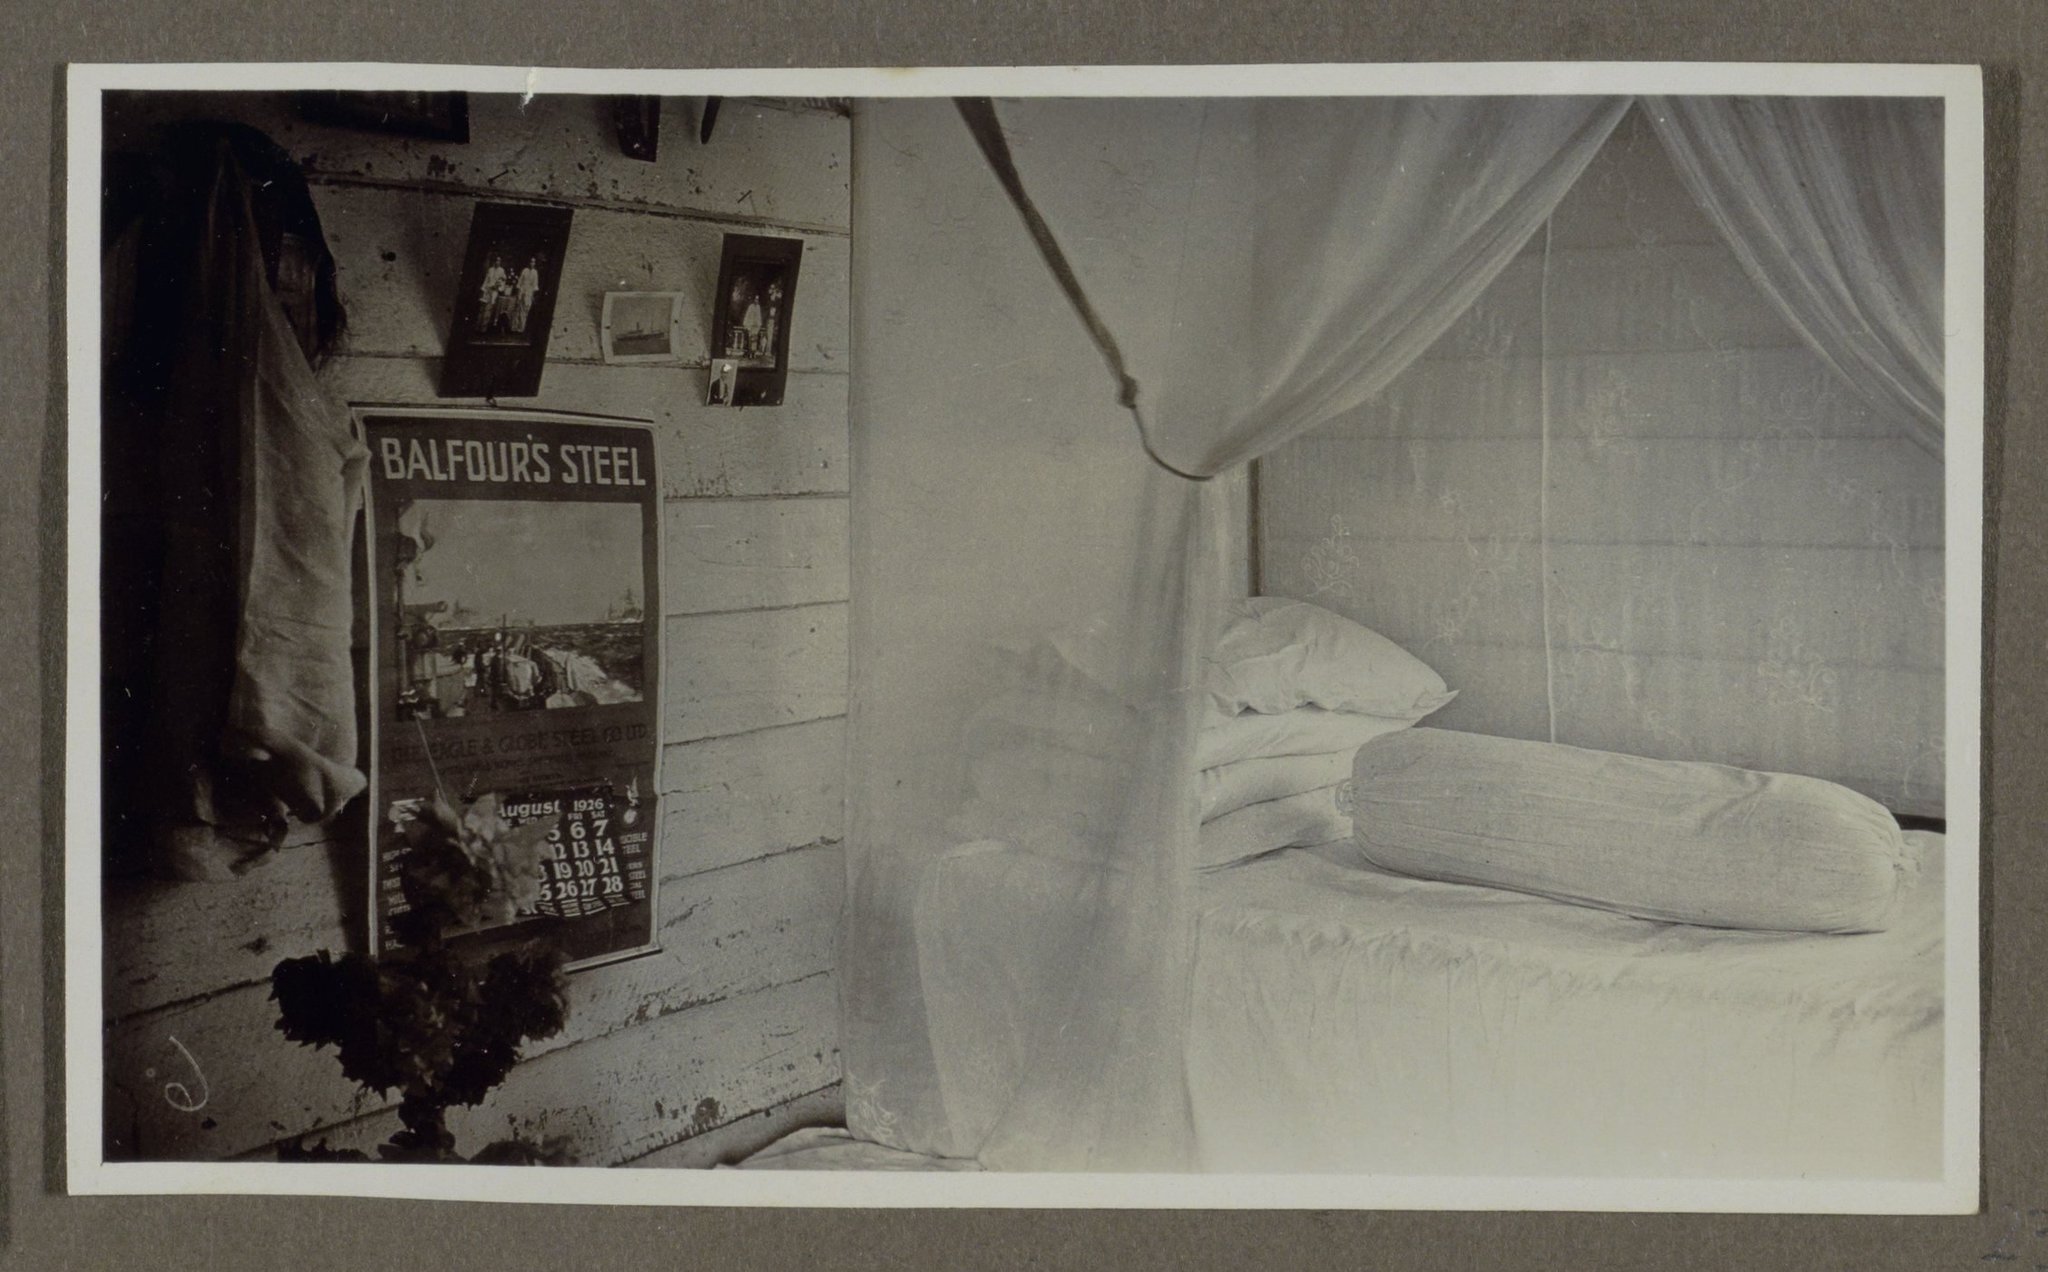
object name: photograph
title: Slaapvertrek met een bed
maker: Anonymous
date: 1926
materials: photographic support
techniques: gelatin silver print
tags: bedroom, dutch east indies, the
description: De muren van de ruimte zijn gemaakt van planken, de verf is afgebladderd. Op het bed kussens, eromheen een klamboe. Links aan de muur foto's en een kalender van Balfour's Steel waarop augustus 1926 vermeld staat. Uiterst links hangt een kledingstuk aan de muur, ervoor staat een bos bloemen. Onderdeel van familiealbum Nederlands-Indië.